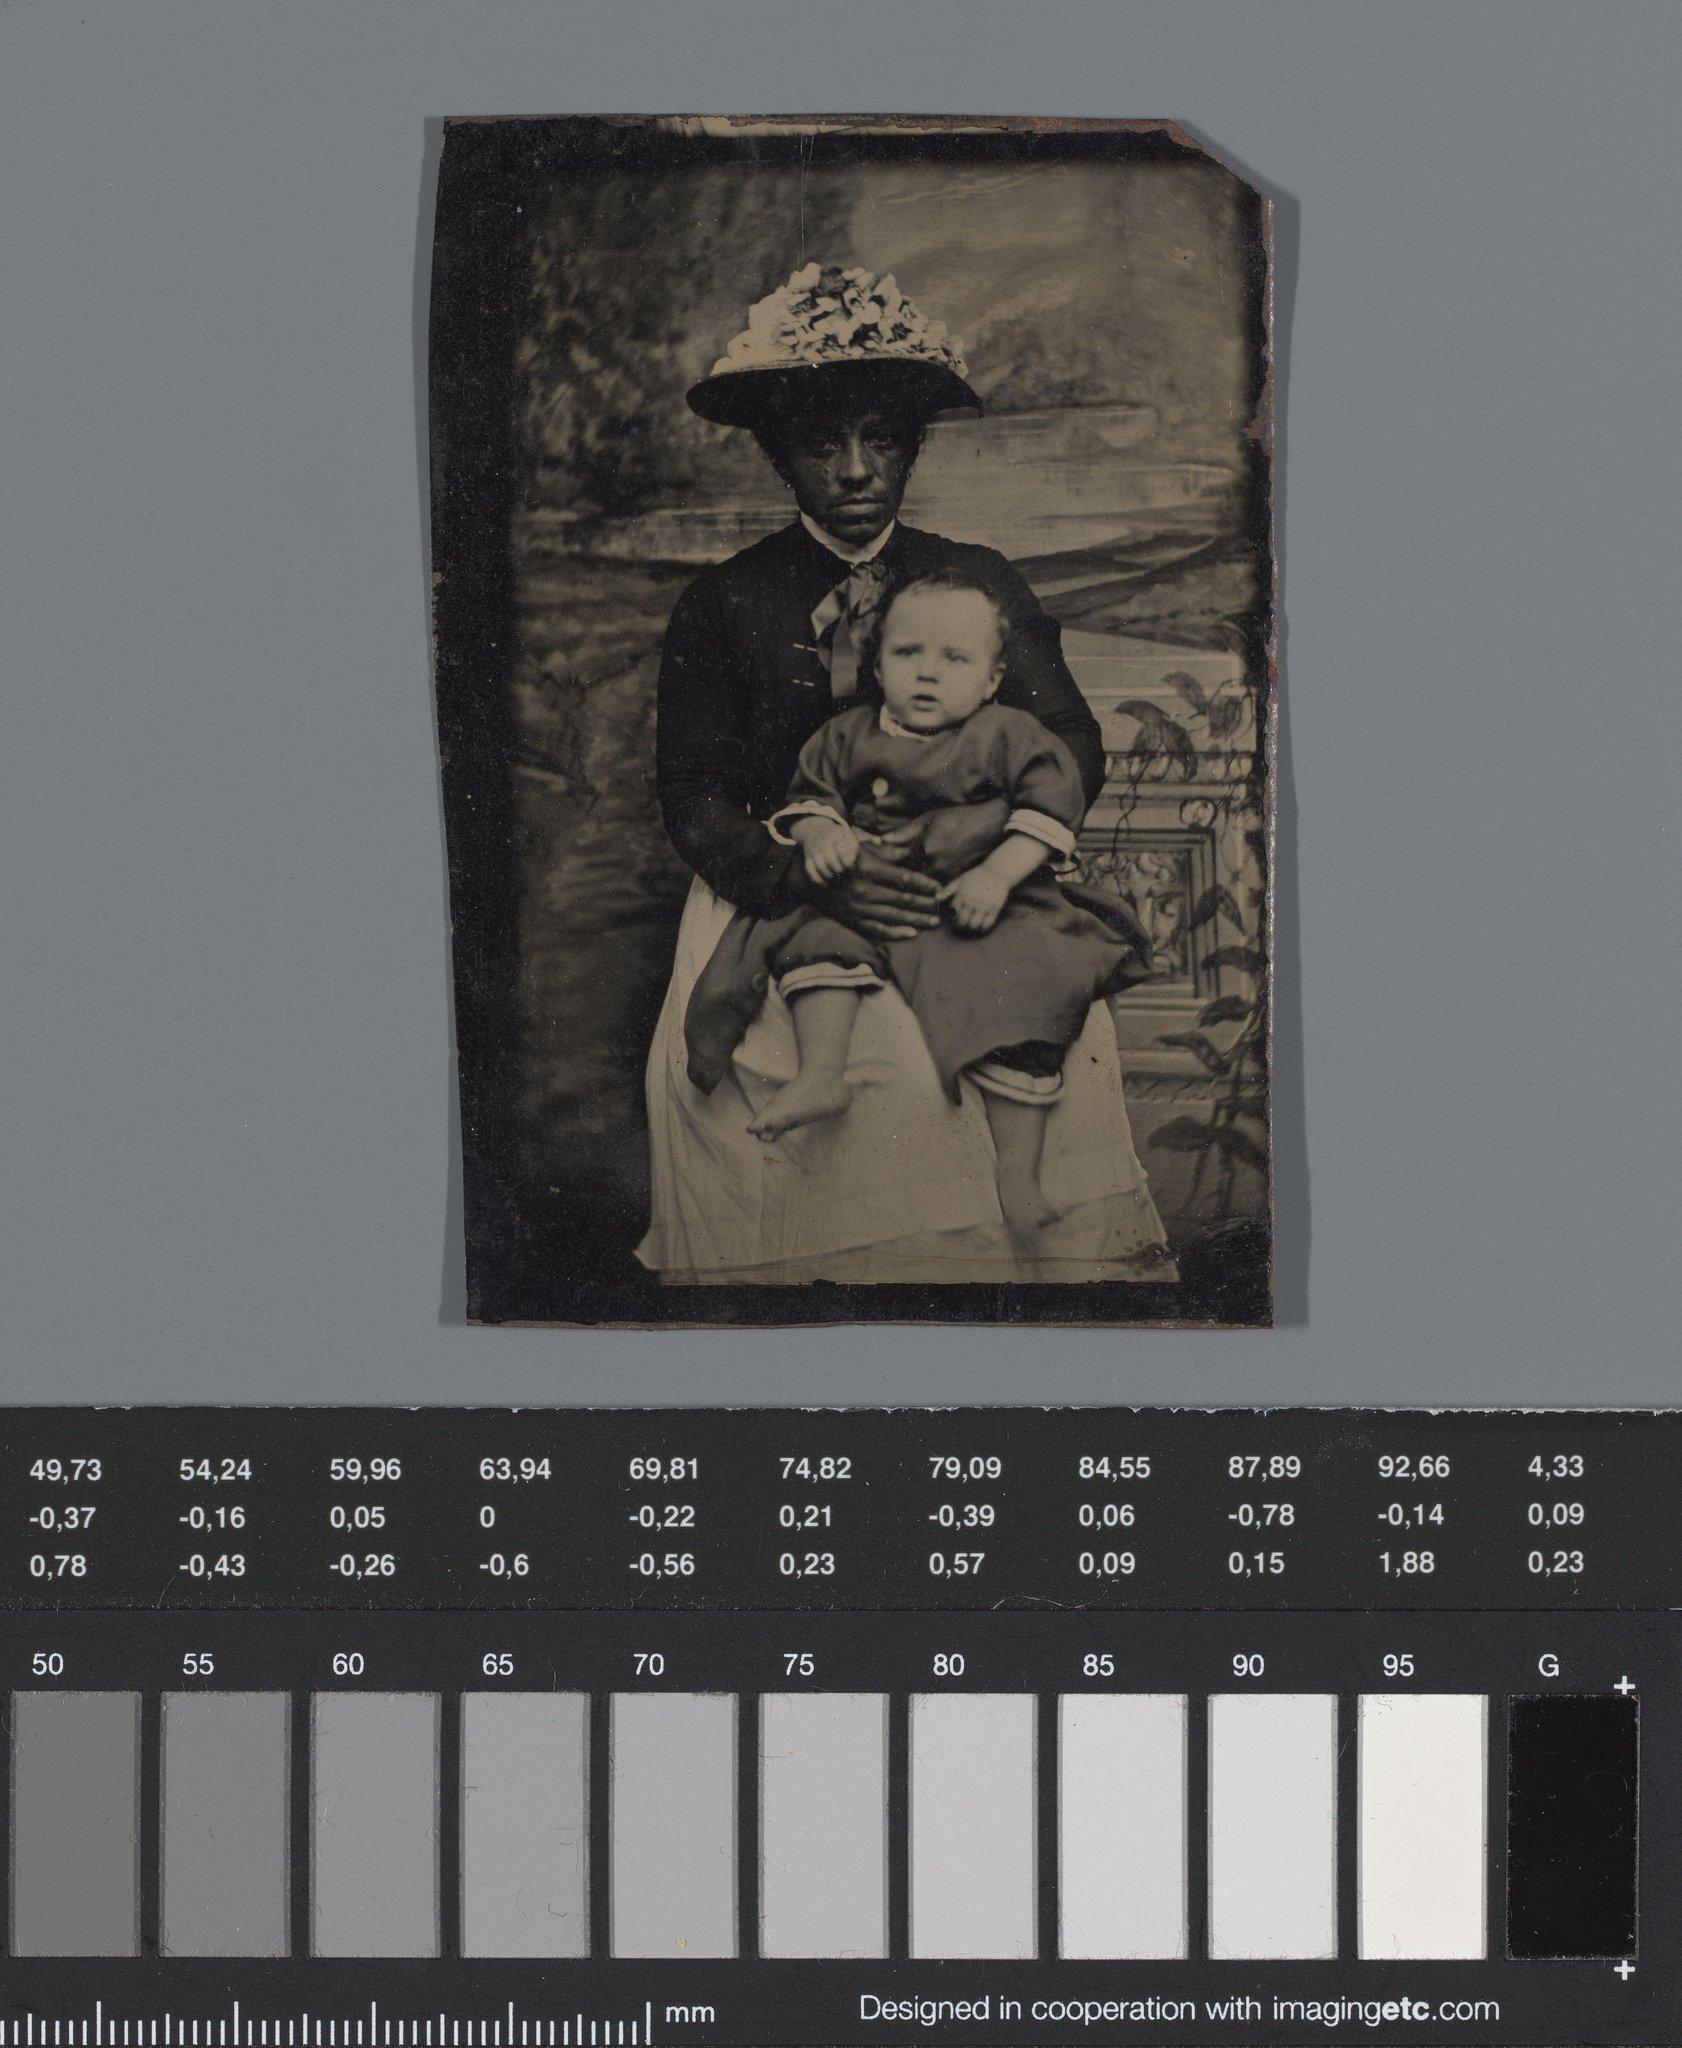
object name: photobook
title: Vrouw met baby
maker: Anonymous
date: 1870-1910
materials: photographic support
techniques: ferrotyping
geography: united states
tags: united states of america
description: Zittende zwarte vrouw met hoed en op schoot een witte peuter tegen een decor met landschap.